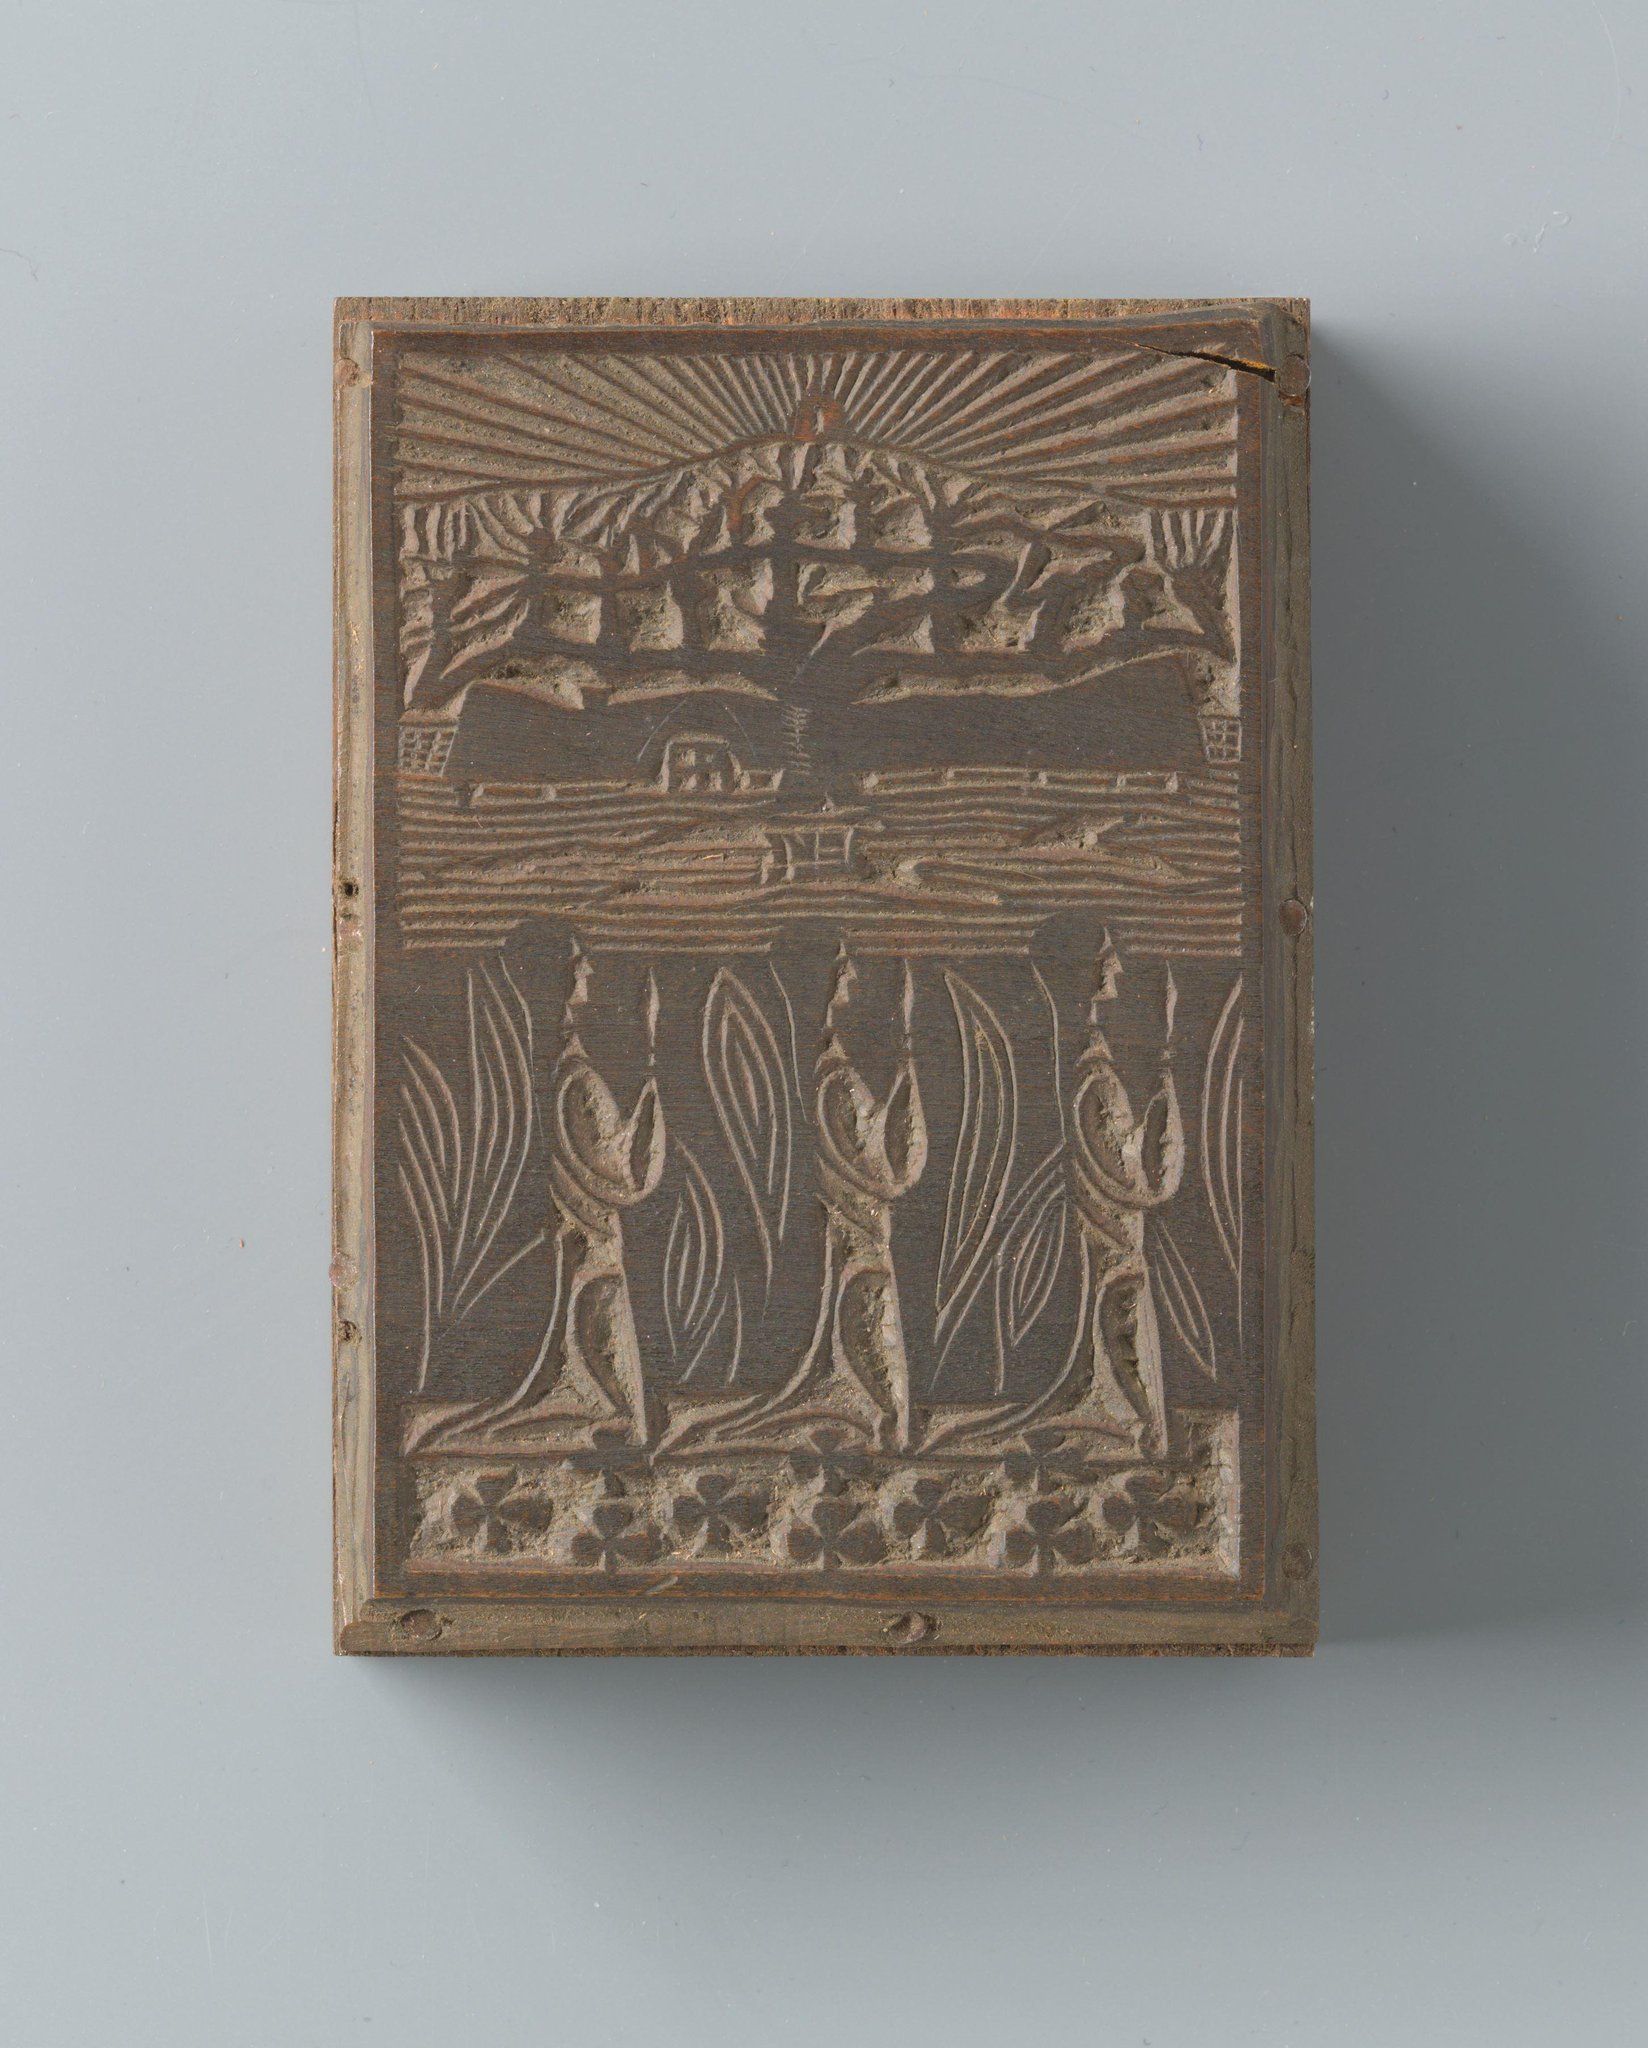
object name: wood block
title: Legende van het Sint-Janskerkhof bij Laren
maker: pieter hendrik van moerkerken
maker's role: print maker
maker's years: 1877-1951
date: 1899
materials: wood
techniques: woodcut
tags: churchyard, cemetery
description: Afdruk waarschijnlijk gepubliceerd in: Moerkerken, Pieter Hendrik van. Dit is de legende van het kerkhof van Sint Ian by Laren. Amsterdam: S.L. van Looy, 1899.